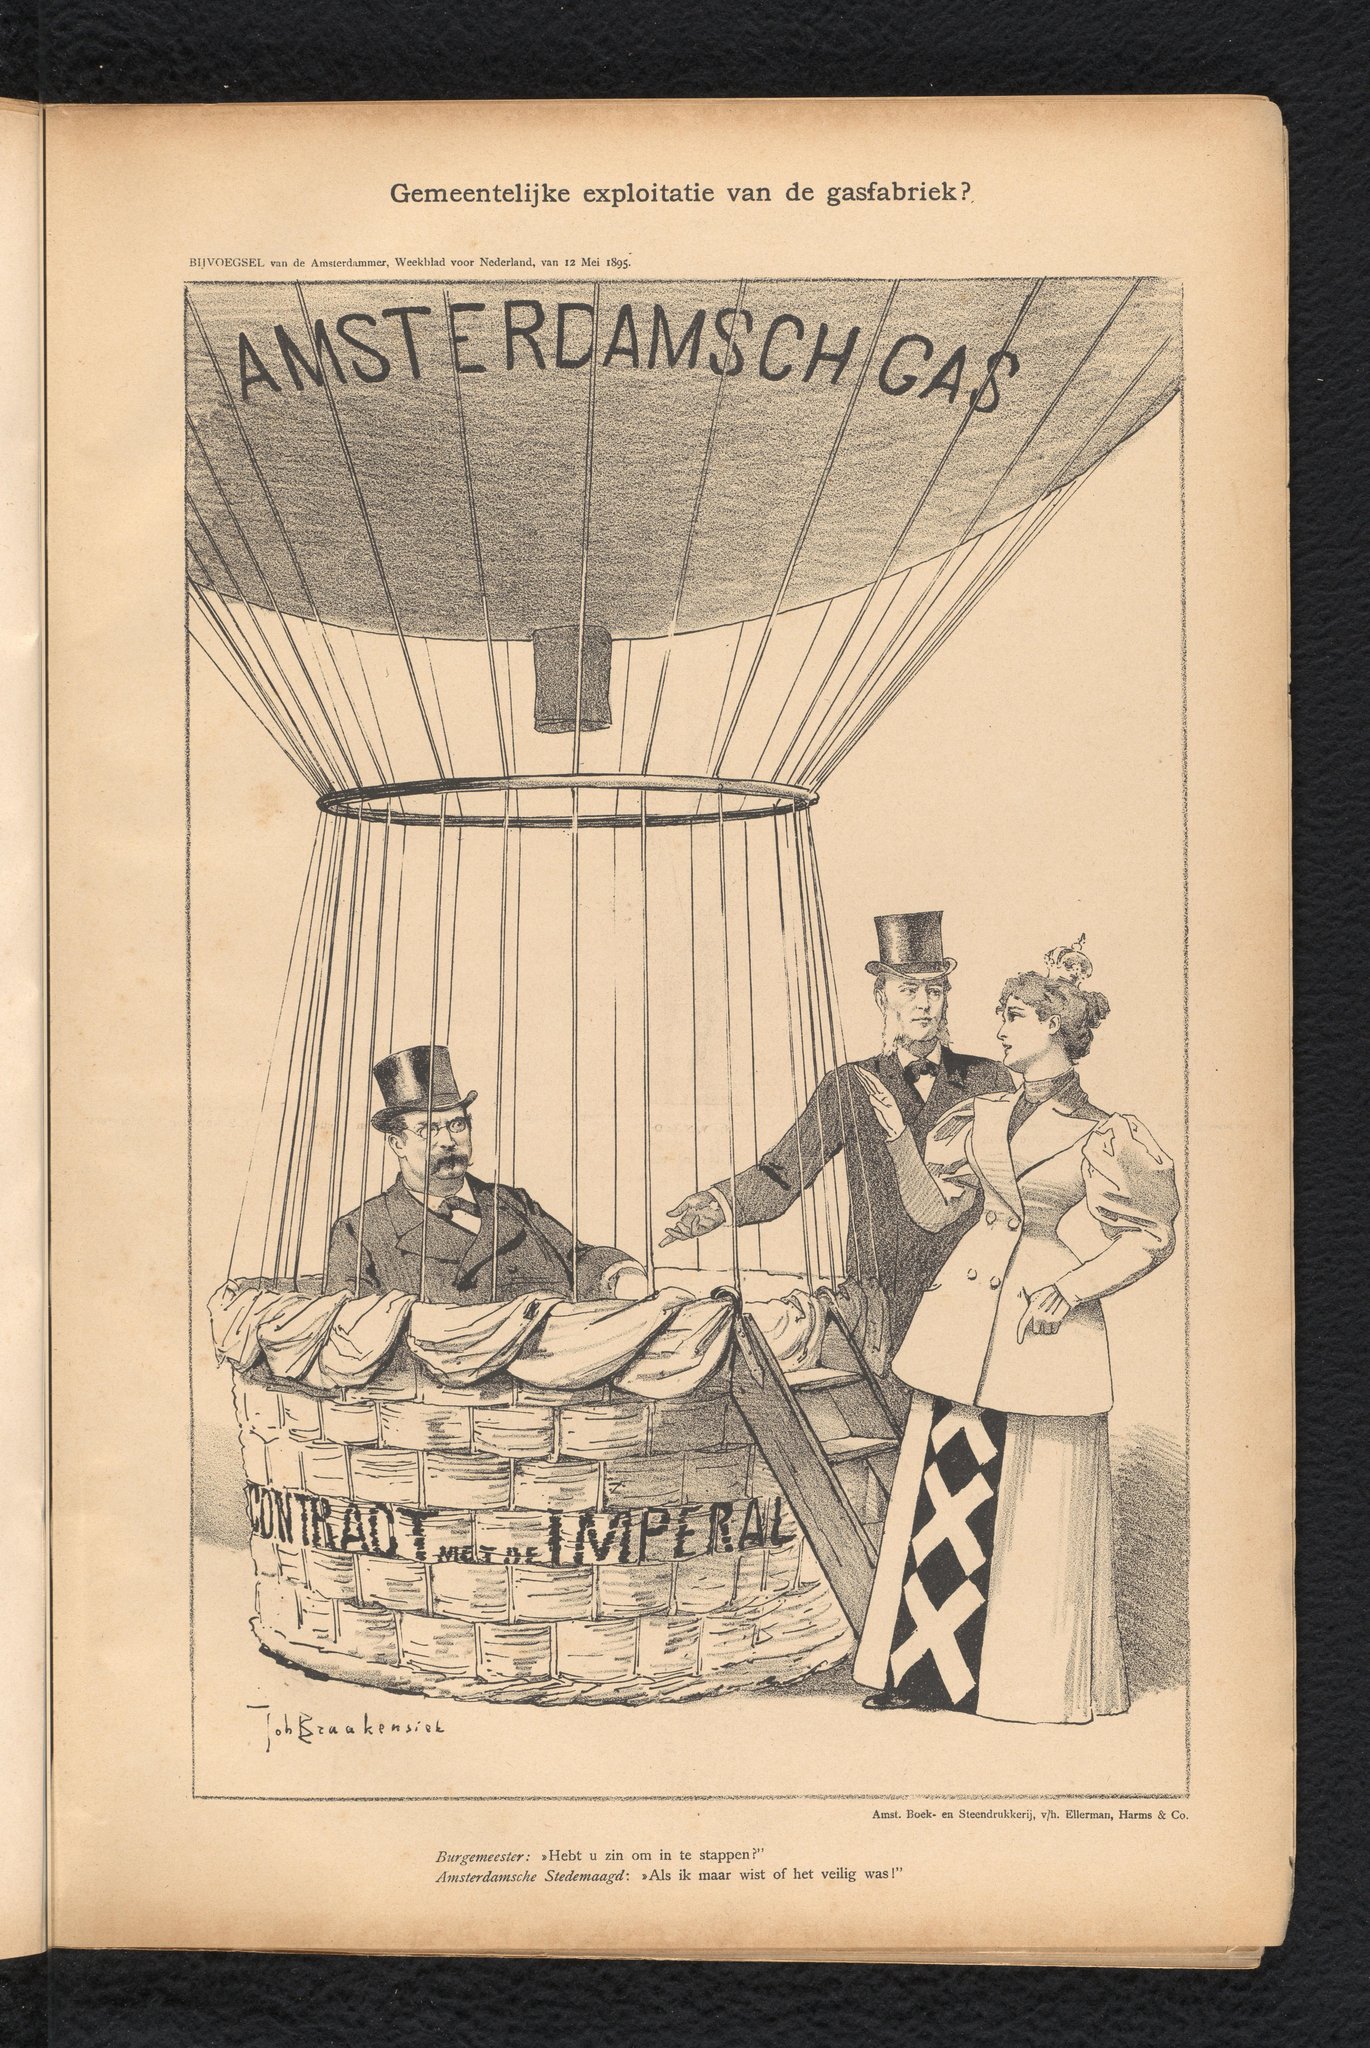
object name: cartoon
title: Gemeentelijke exploitatie van de gasfabriek?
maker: johan braakensiek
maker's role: draughtsman, print maker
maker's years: 1858-1940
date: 1895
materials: paper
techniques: lithograph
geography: amsterdam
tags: gasworks, personification of a city, town-patron(ess), balloon flight (sport), balloon (aviation), political caricatures and satires, amsterdam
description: Burgemeester Vening Meinesz, nodigt de Amsterdamse Stedemaagd uit om aan boord te gaan van een heteluchtballon gevuld met Amsterdamsch Gas.